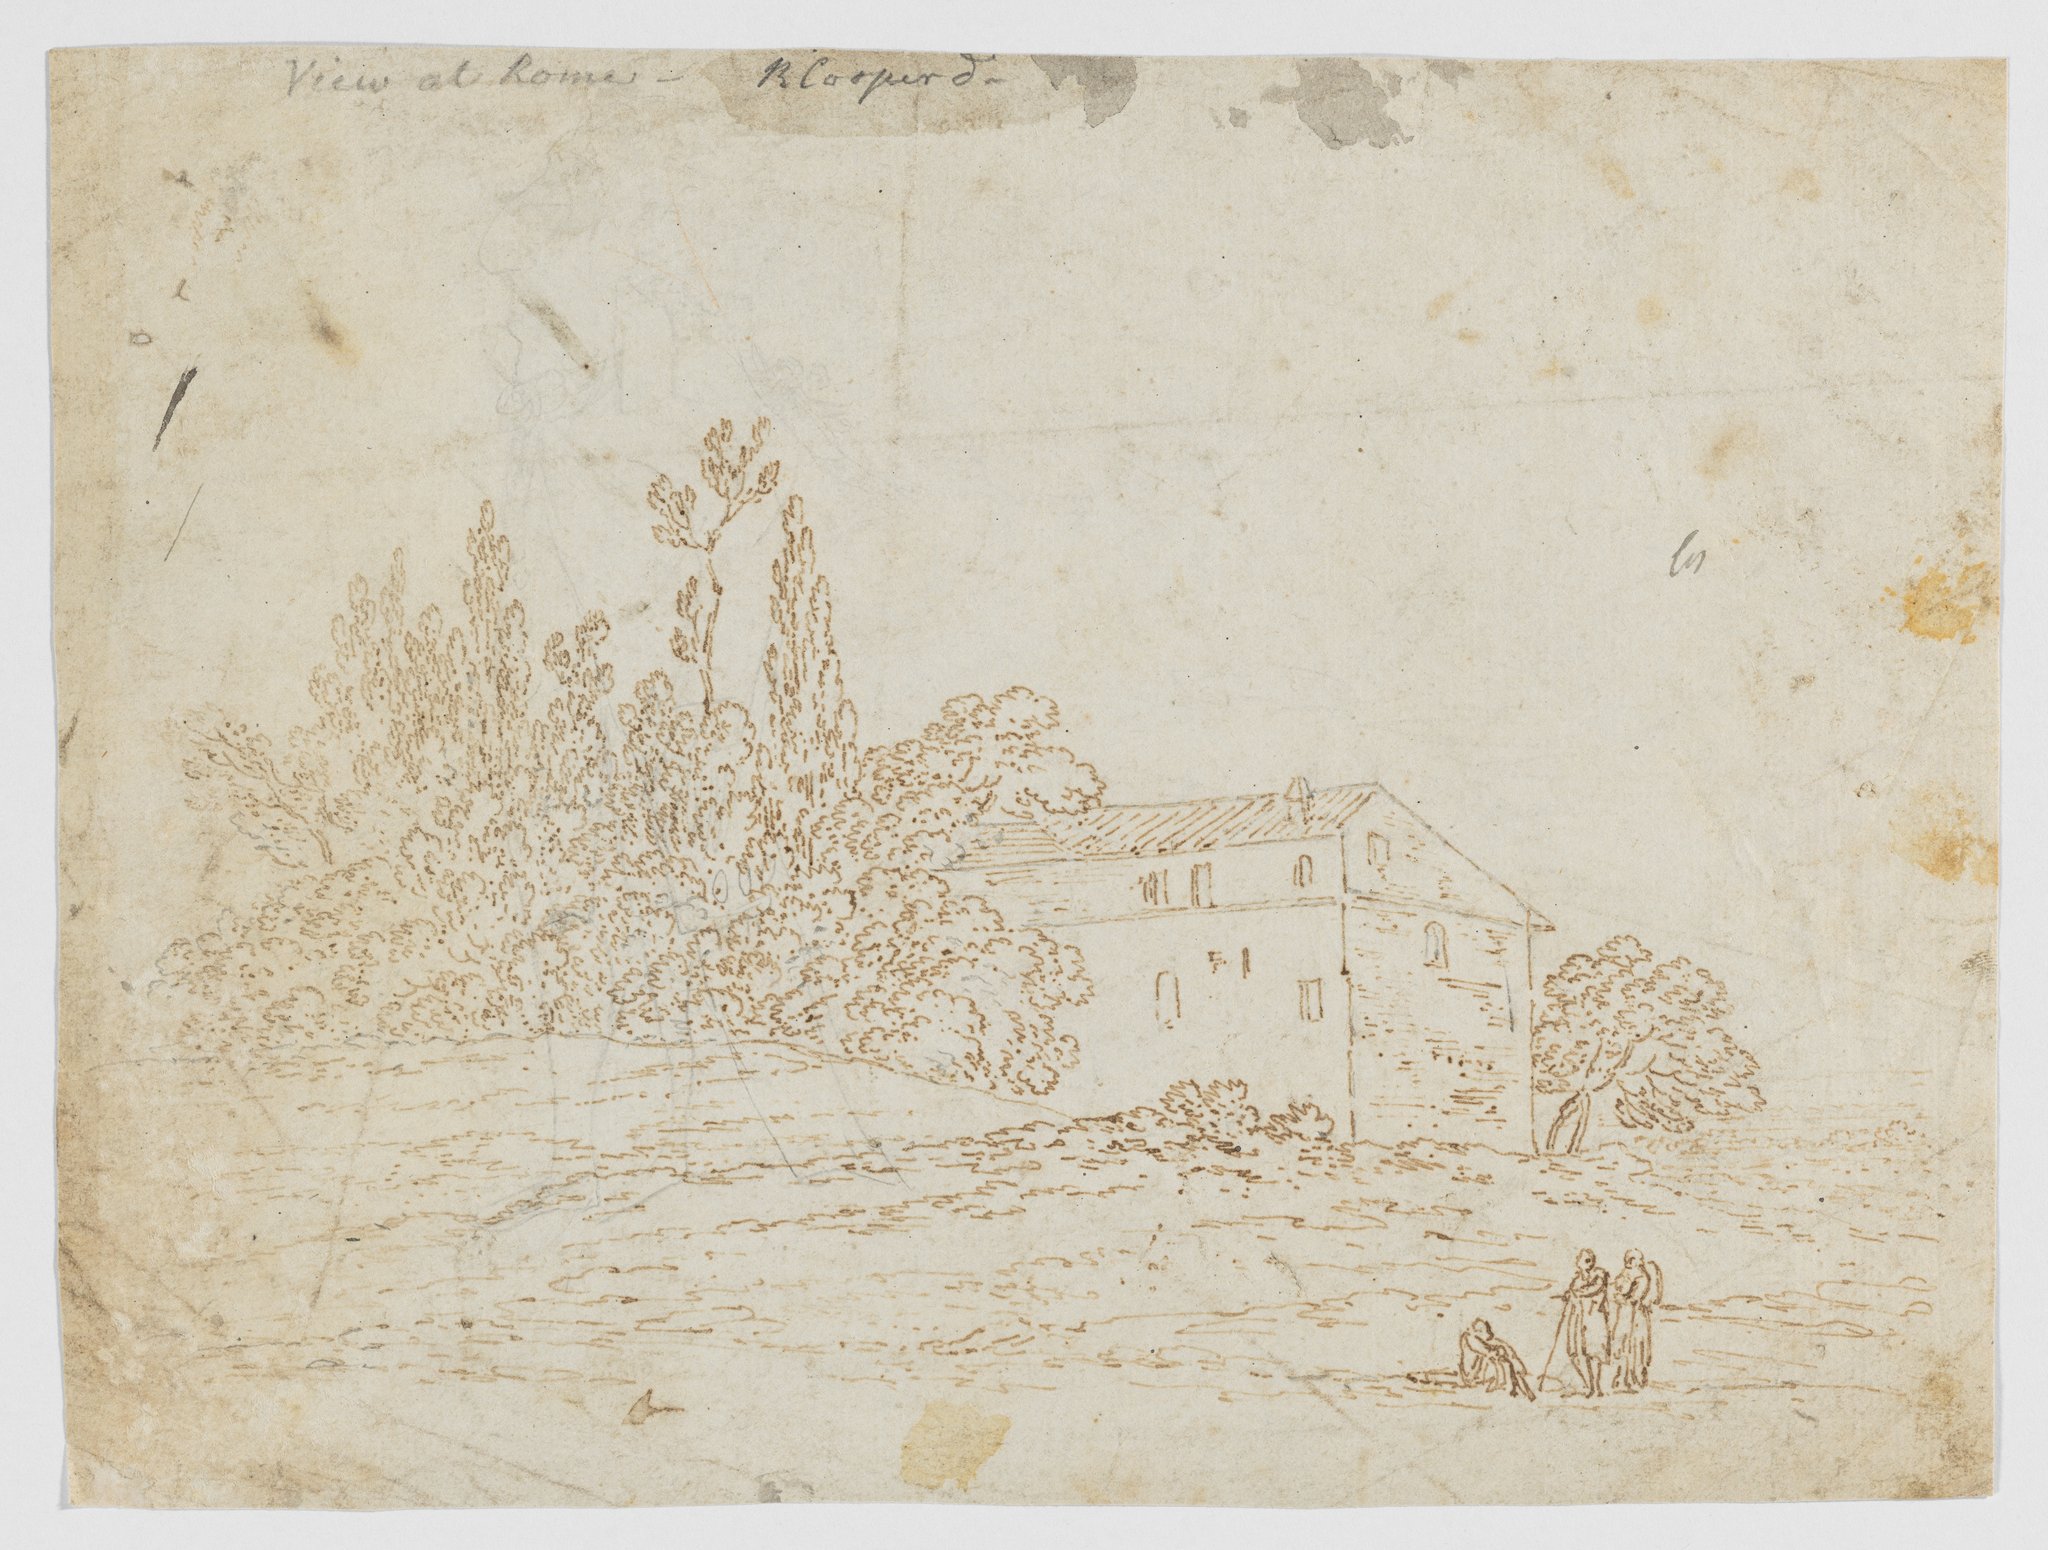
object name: drawing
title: View at Rome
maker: richard cooper ii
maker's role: artist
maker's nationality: british, scottish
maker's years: 1740-1822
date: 1774-1775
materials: graphite, ink, iron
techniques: printmaking, drawing